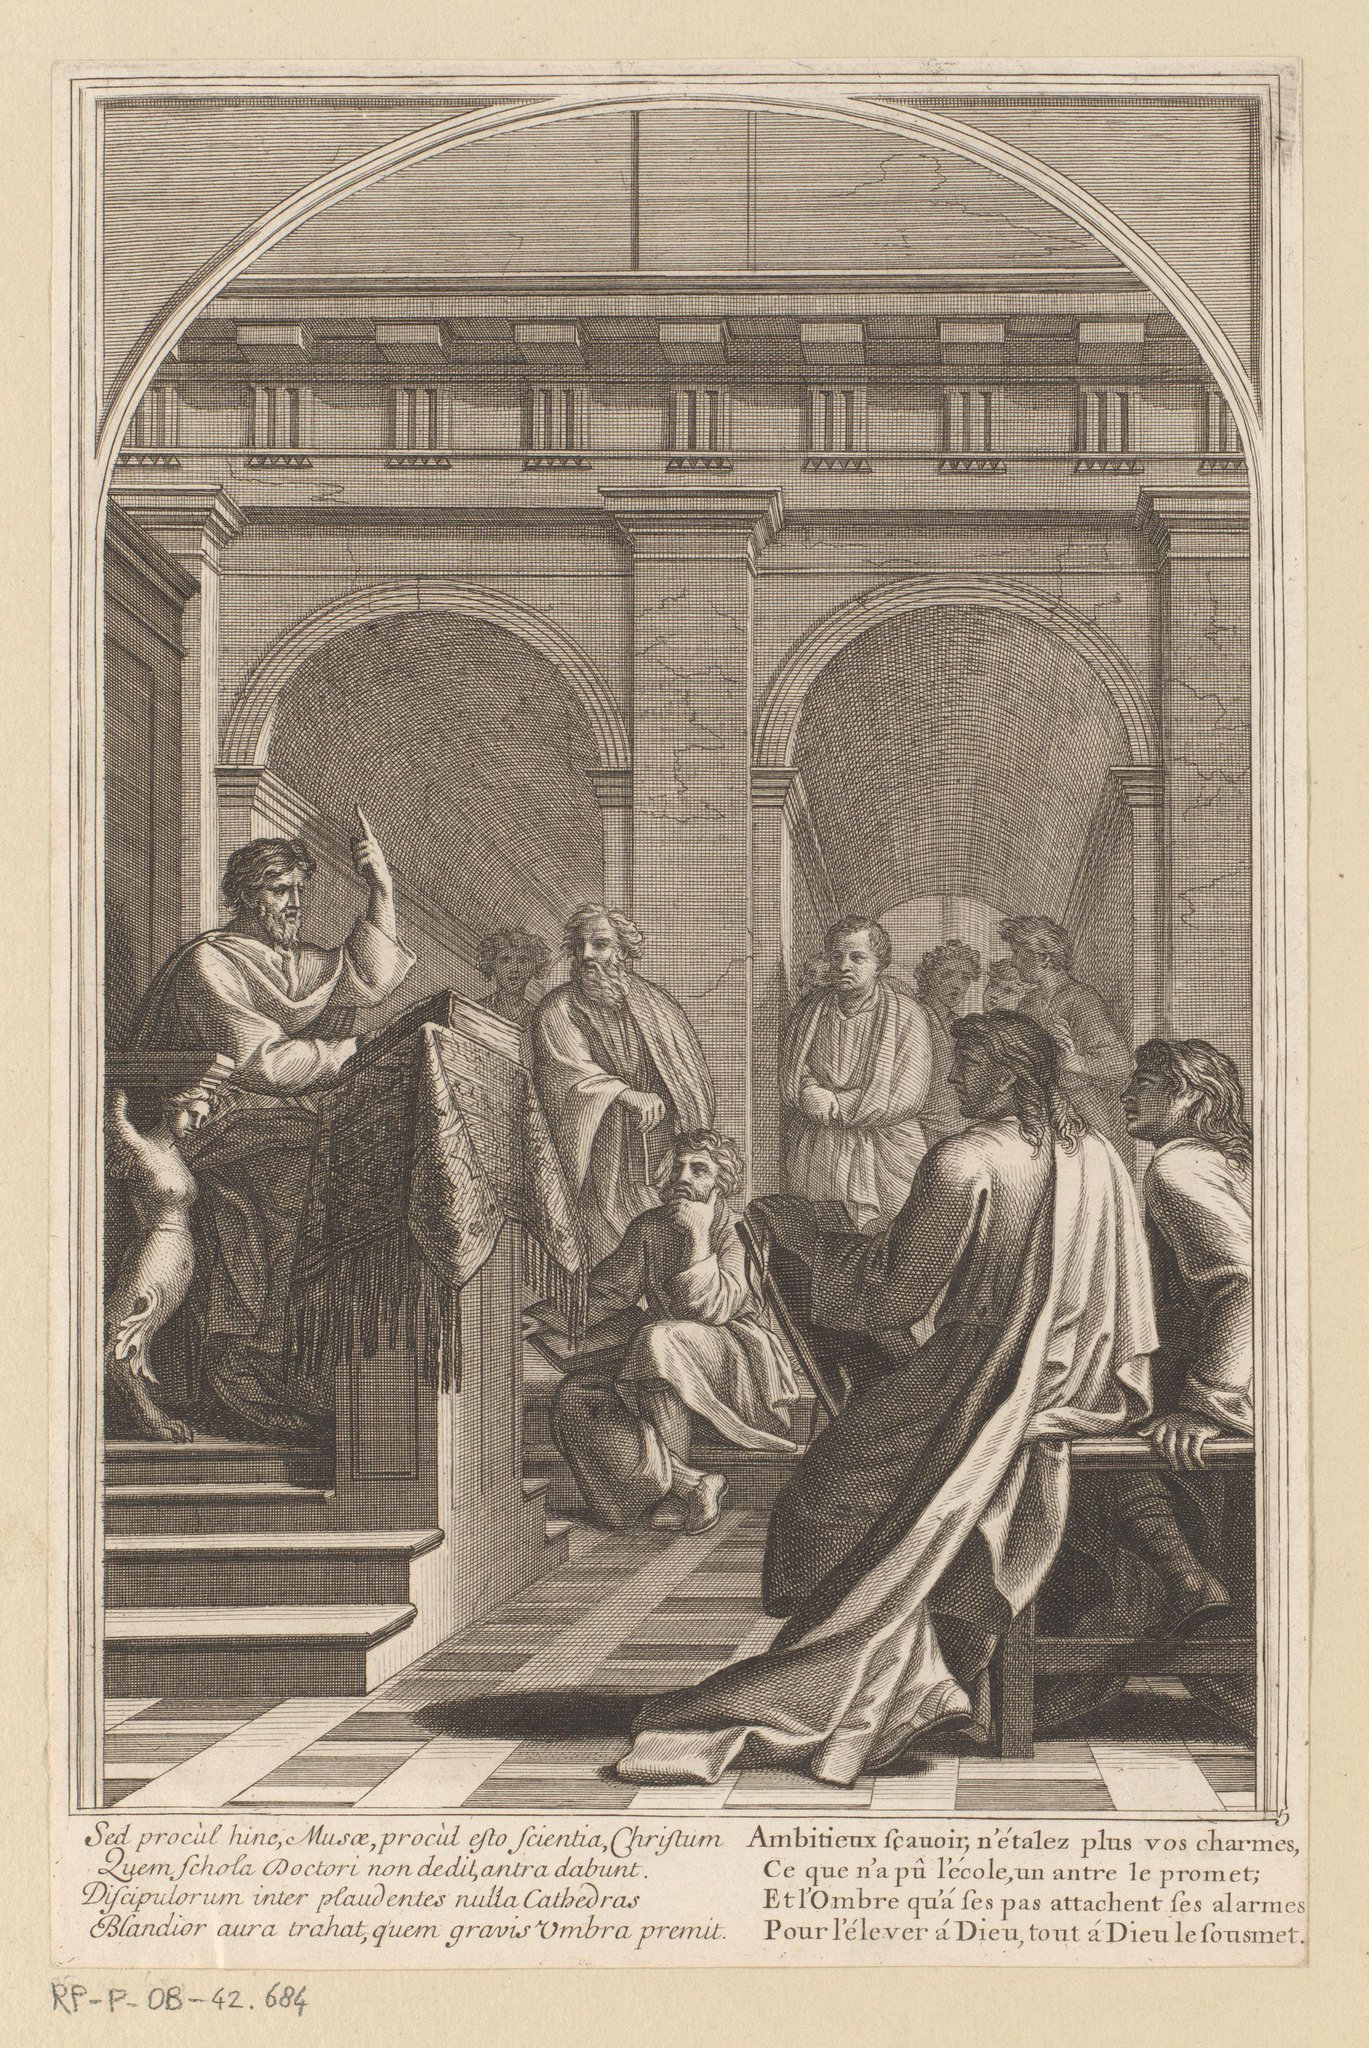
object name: print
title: Heilige Bruno onderwijst theologie in Reims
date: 1623-1676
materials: paper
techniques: engraving, etching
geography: france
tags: the founder of the order of the carthusians, bruno; possible attributes: cross, finger at lips, lily, mitre at his feet, olive-branch, ray of light, skull, (seven) star(s), the founder of the order of the carthusians, bruno; possible attributes: cross, finger at lips, lily, mitre at his feet, olive-branch, ray of light, skull, (seven) star(s) - male saint writing, studying, teaching, dictating (e.g. as doctor of the church)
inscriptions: collector's mark: Lugt 2165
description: Maakt deel uit van een serie met 24 prenten (inclusief twee titelprenten), naar schilderijen door Lesueur vervaardigd tussen 1645-1648 voor de Chartreuse de Paris. De serie is getiteld: La vie de St. Bruno fondateur de l'Ordre des Chartreux peinte au cloistre de la Chartreuse de Paris par Eustache Le Sueur.